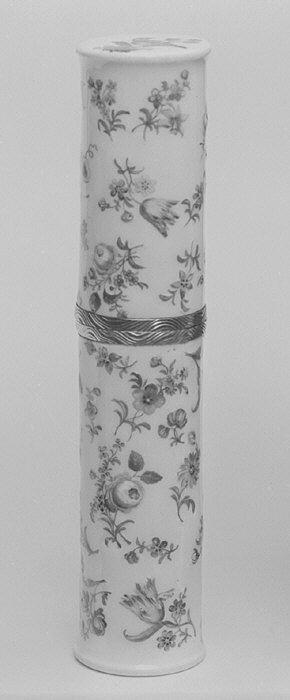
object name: needle case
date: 1734-1766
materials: gold, hard paste porcelain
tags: flowers